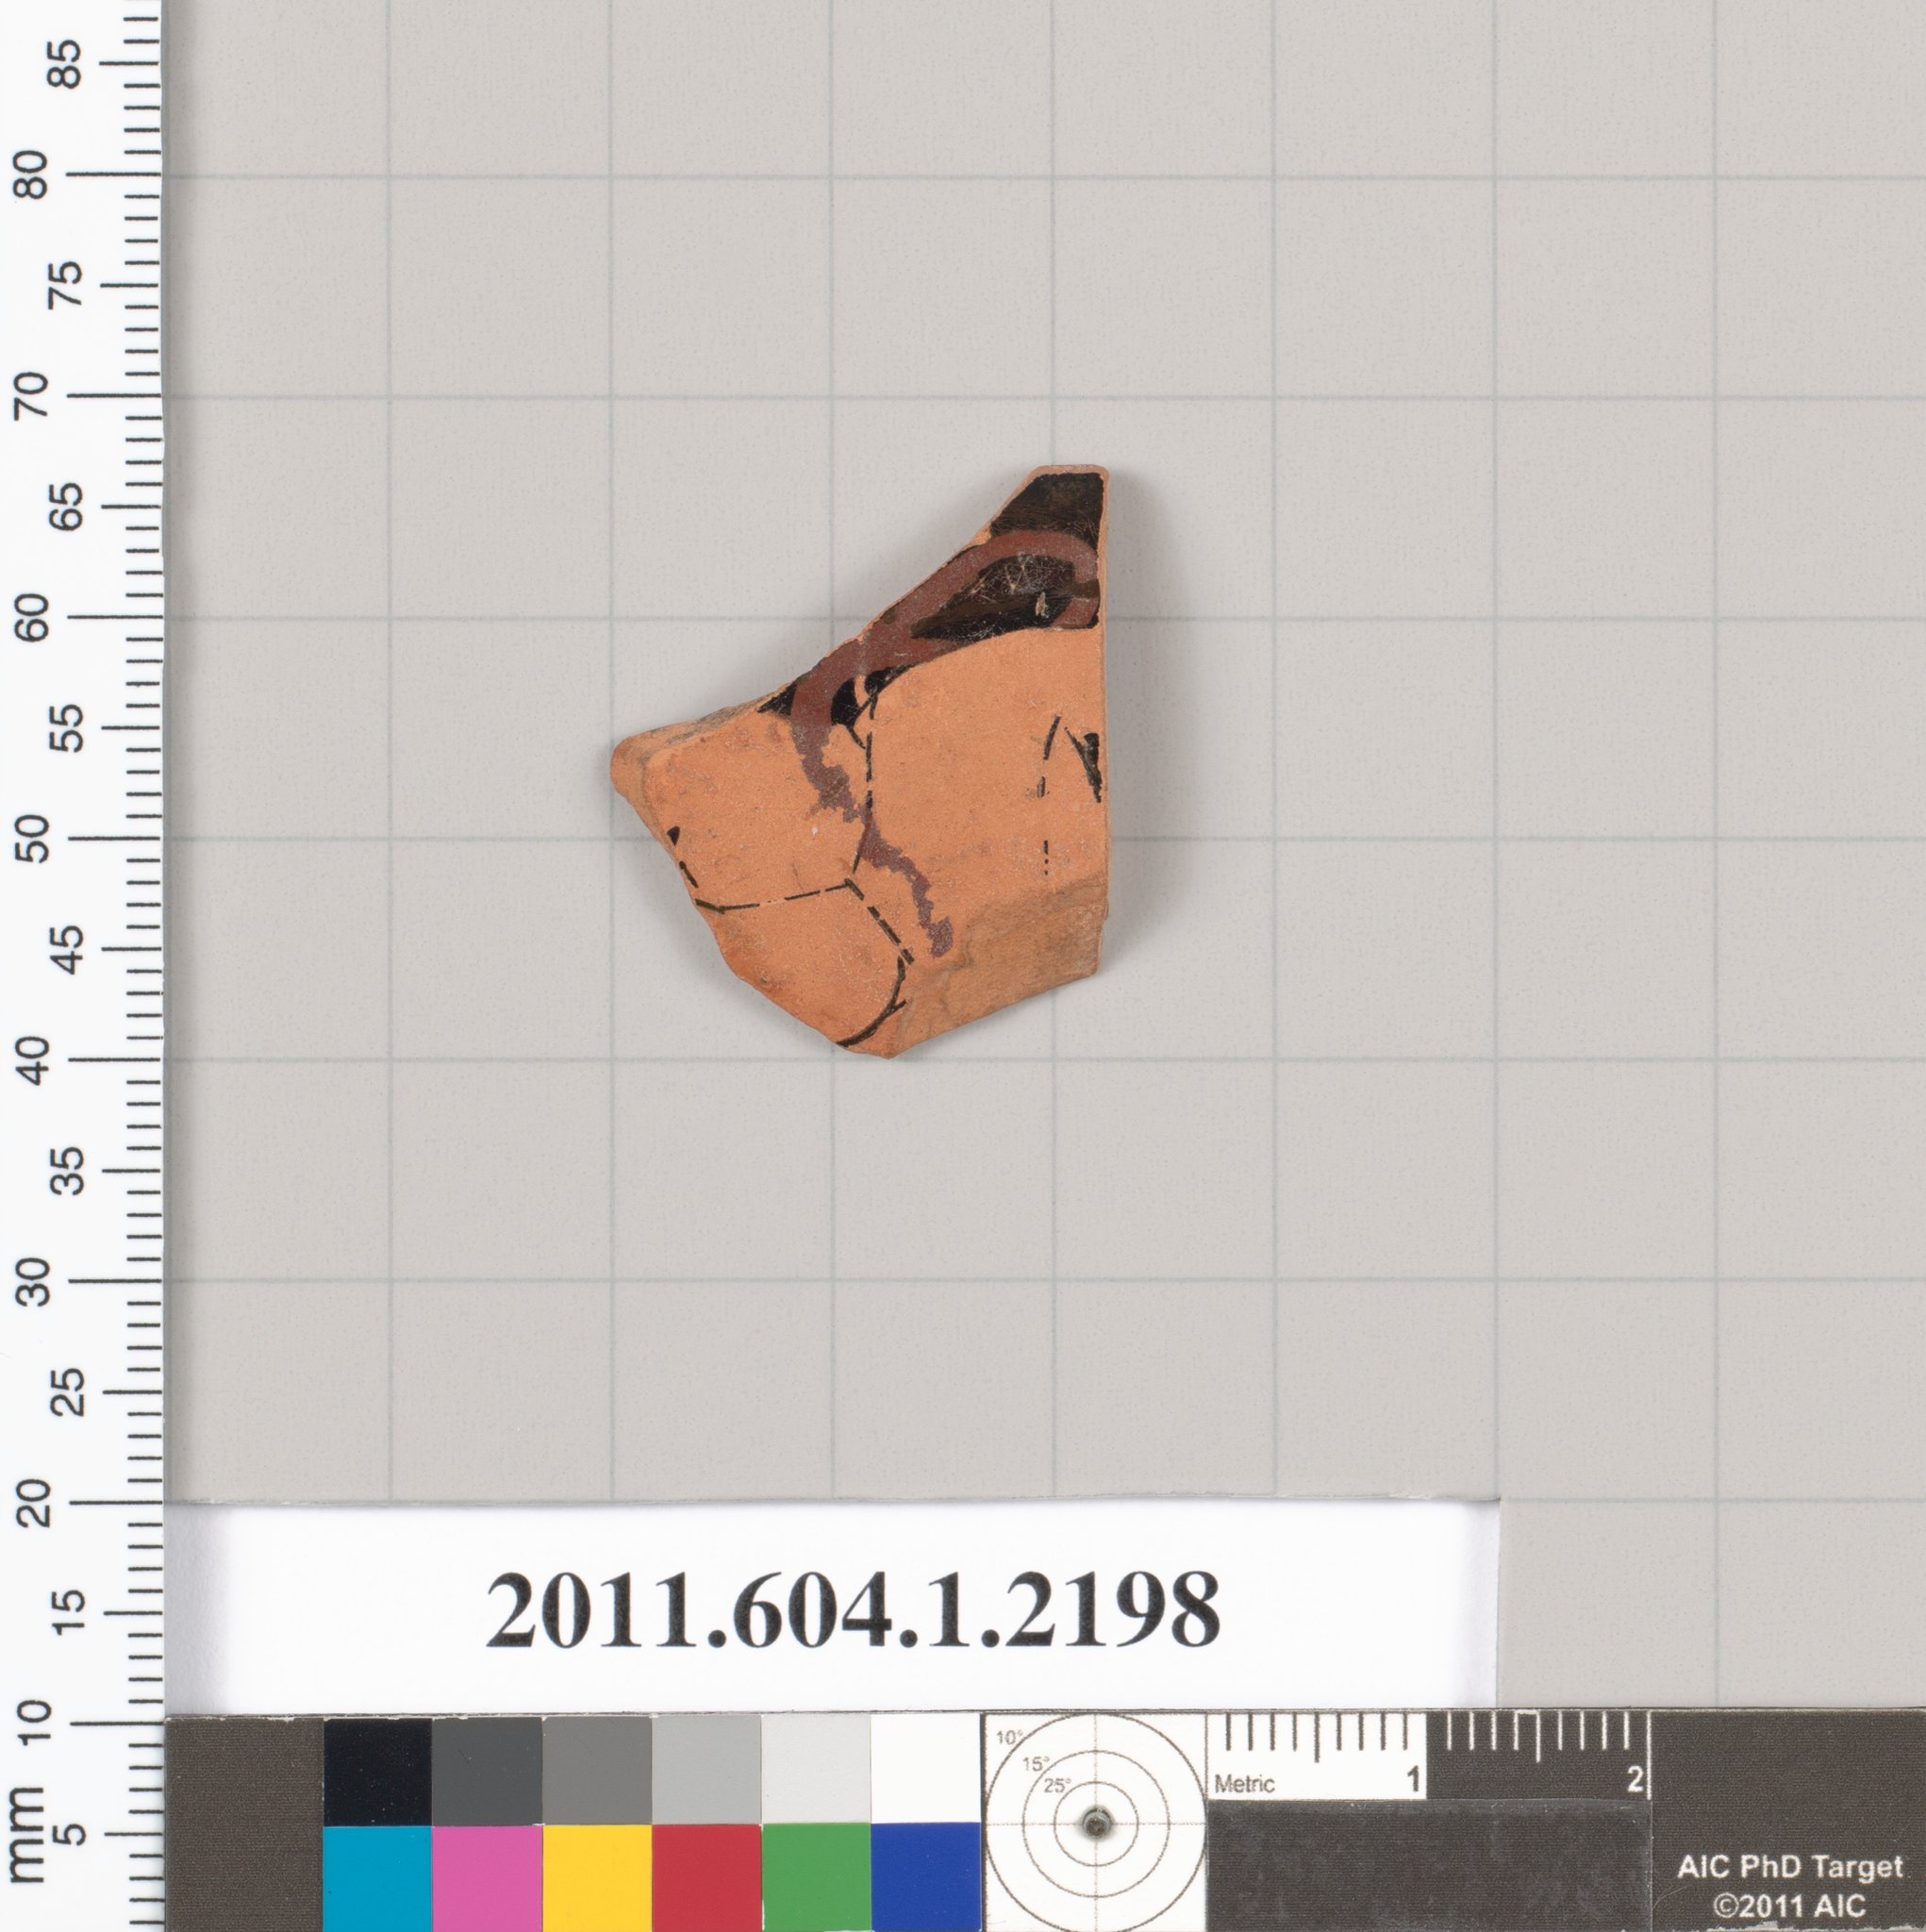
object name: kylix fragment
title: Terracotta rim fragment of a kylix (drinking cup)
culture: greek, attic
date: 490-480 BCE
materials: terracotta